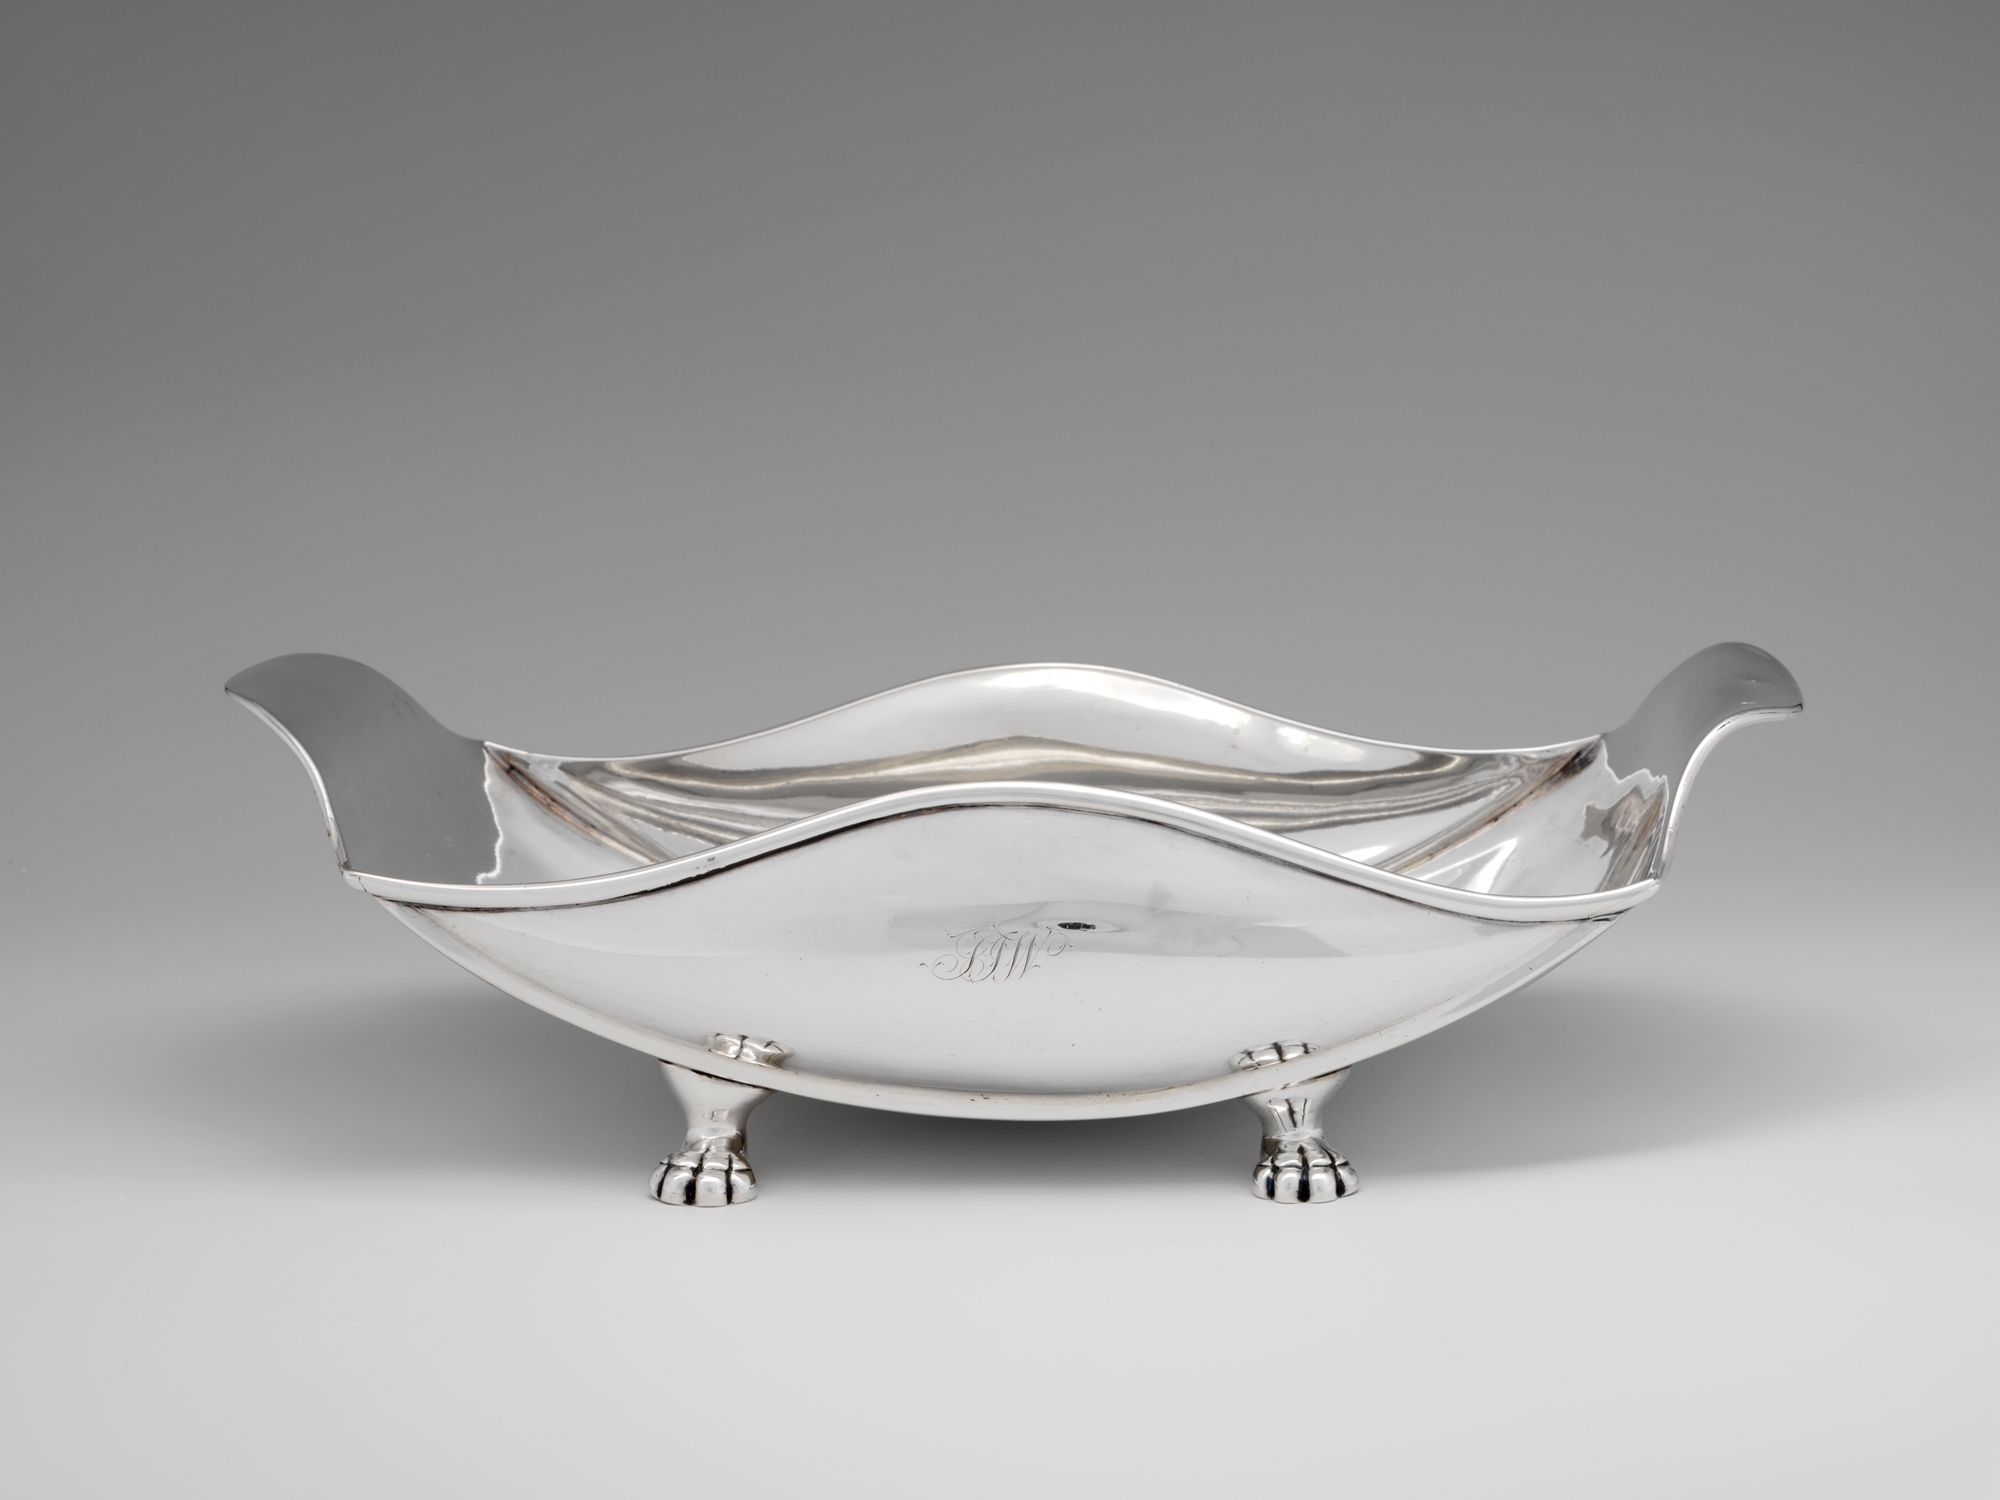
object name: dish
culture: american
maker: frederick marquand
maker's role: maker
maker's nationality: american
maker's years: 1799-1882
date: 1830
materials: silver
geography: united states